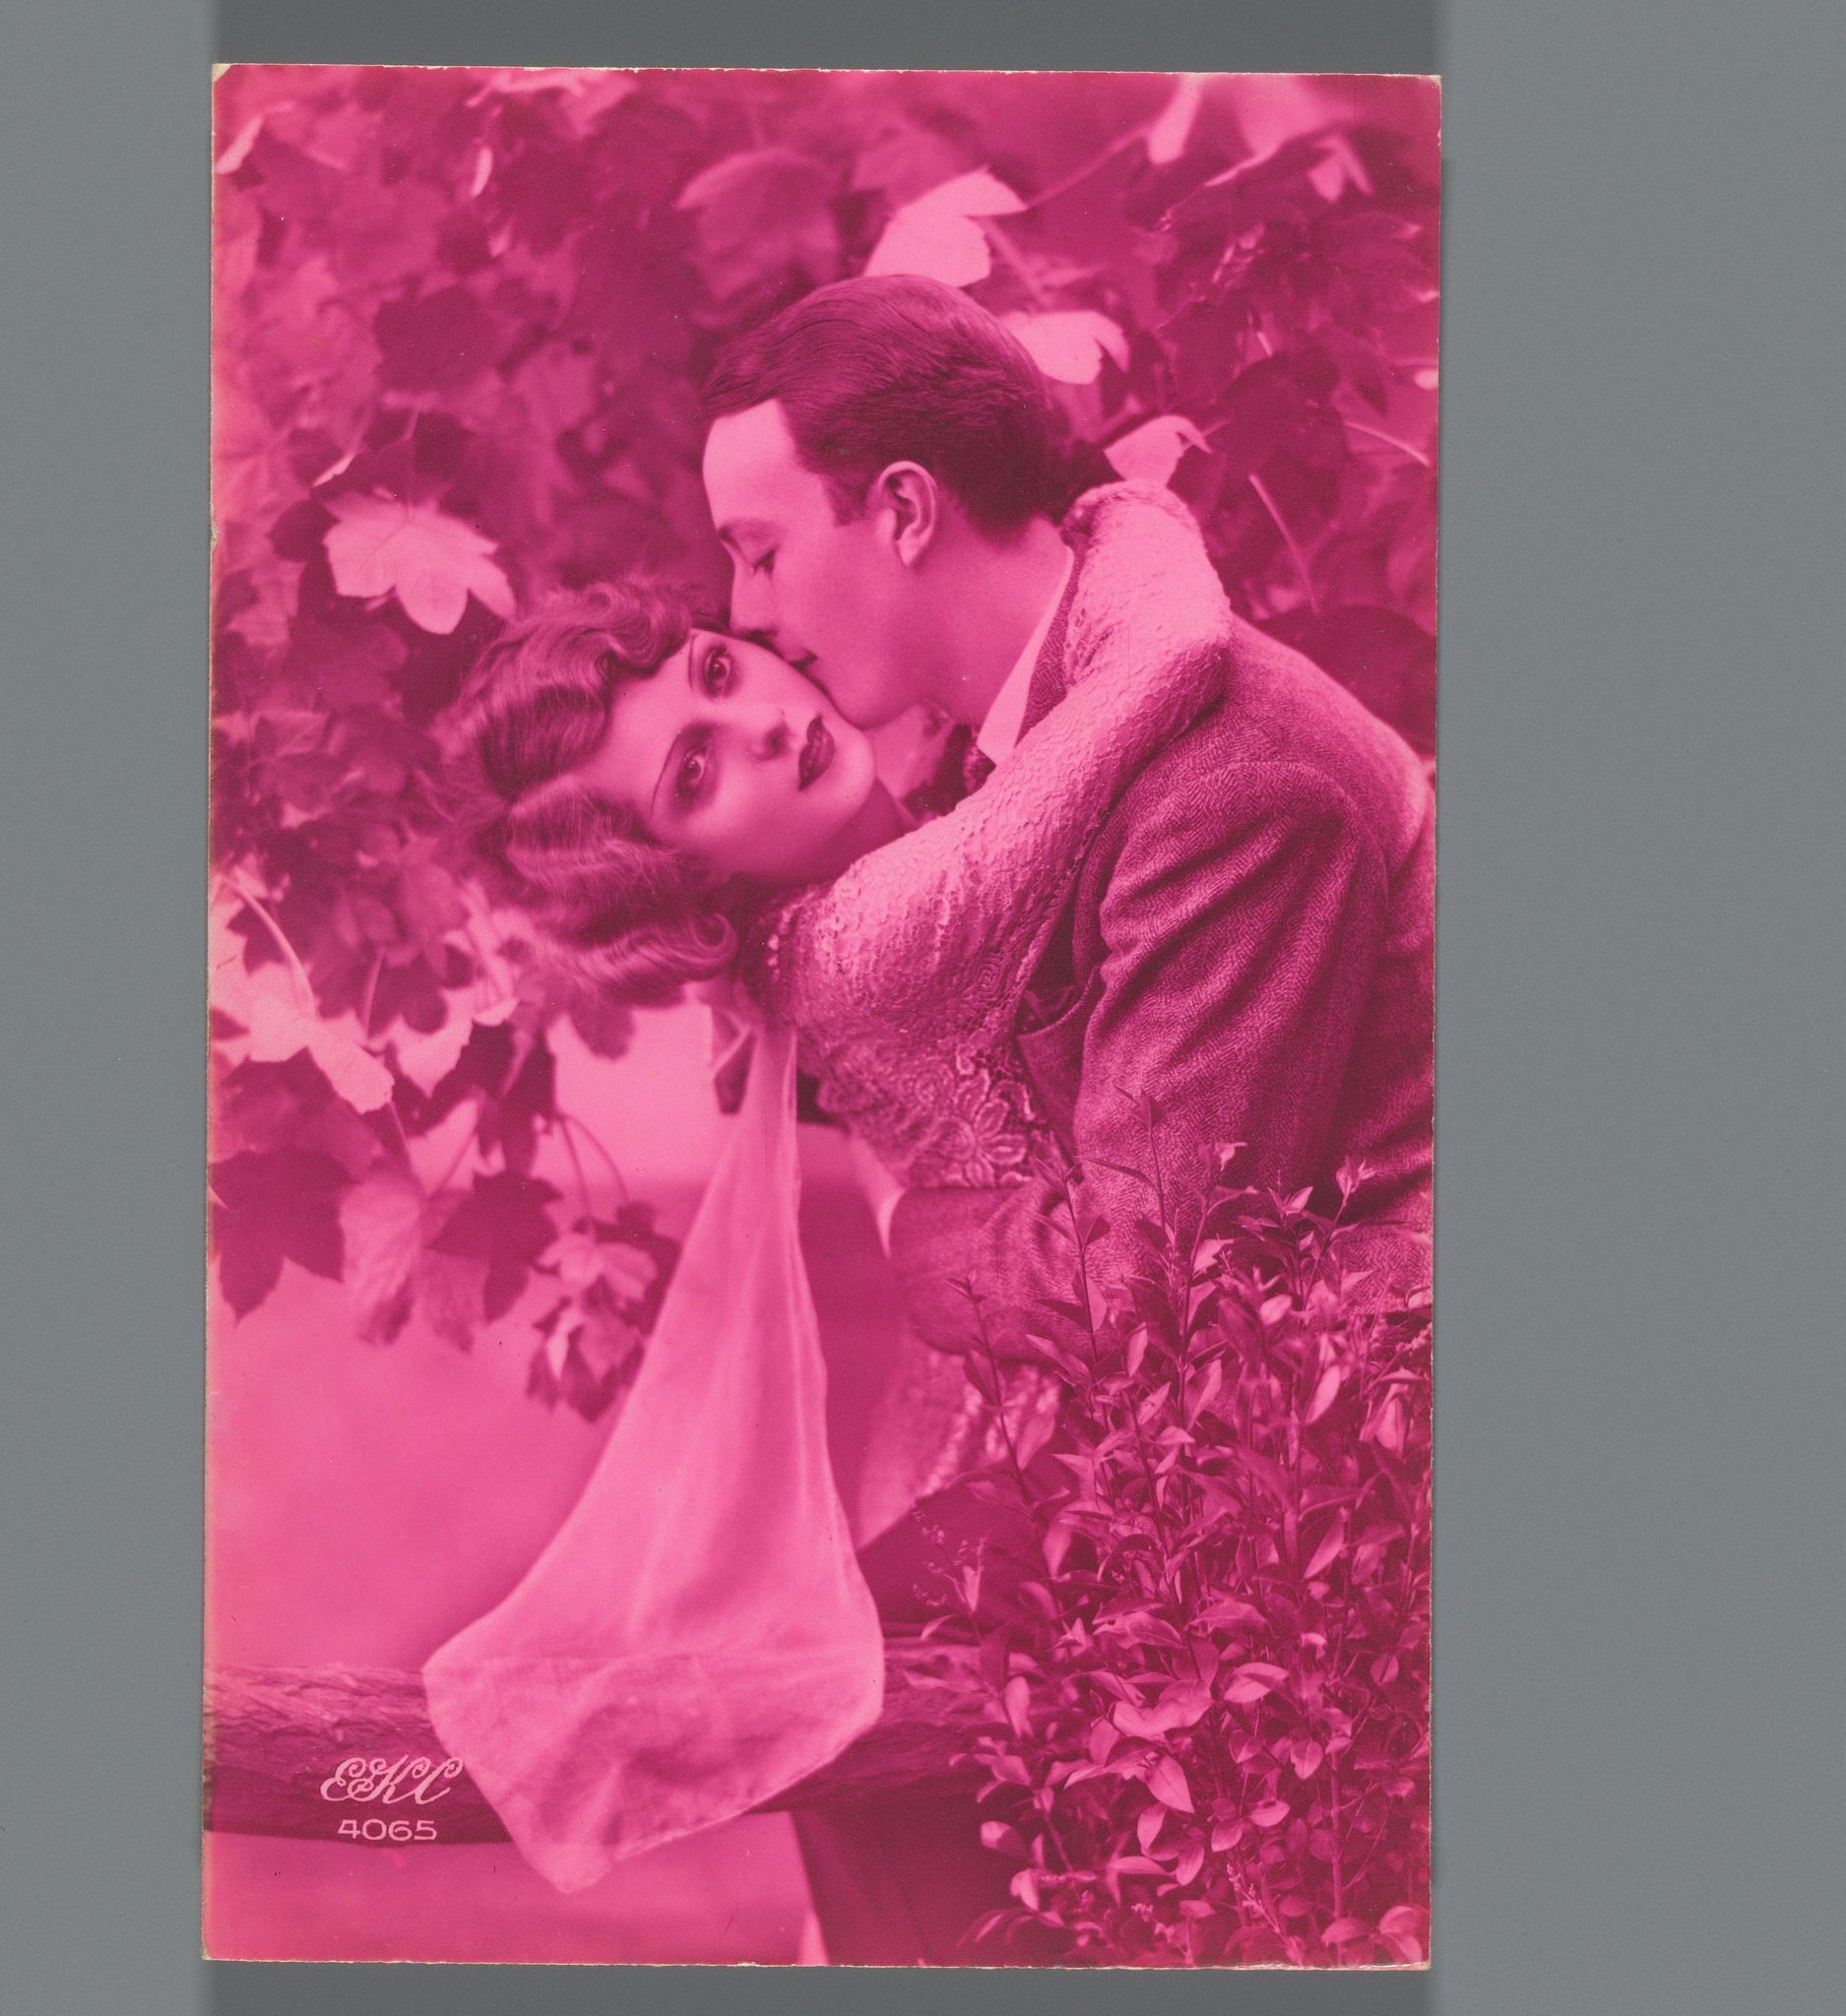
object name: photograph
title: Portret van een onbekend kussend stel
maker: Anonymous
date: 1920-1940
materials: paper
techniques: gelatin silver print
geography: rochester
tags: anonymous historical persons portrayed in a double portrait, couple of lovers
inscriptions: number: ‘4065’